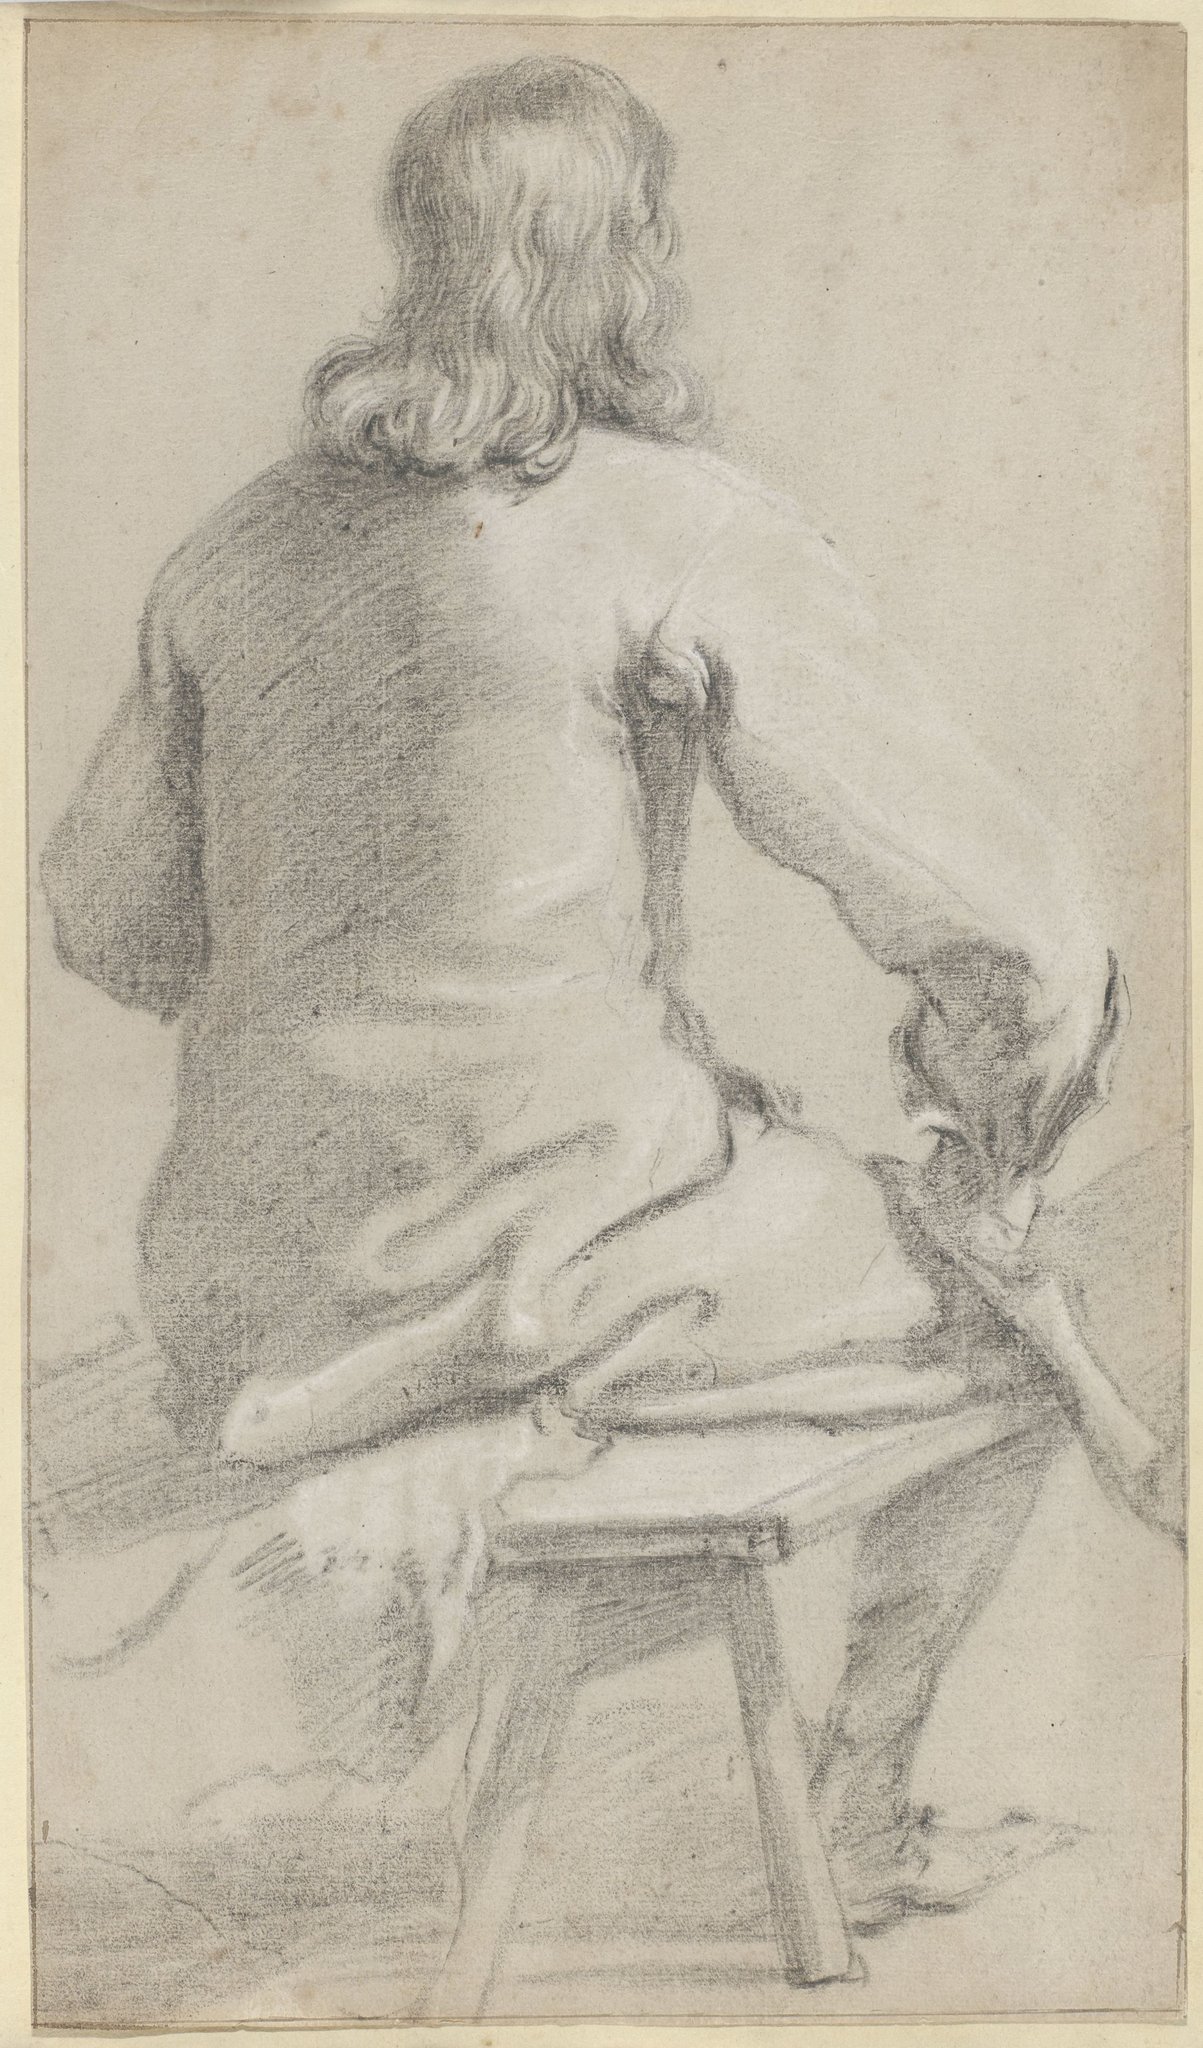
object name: drawing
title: Zittende man op de rug gezien, zijn hoed in zijn hand op zijn knie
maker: Anonymous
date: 1600-1699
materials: chalk, paper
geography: netherlands